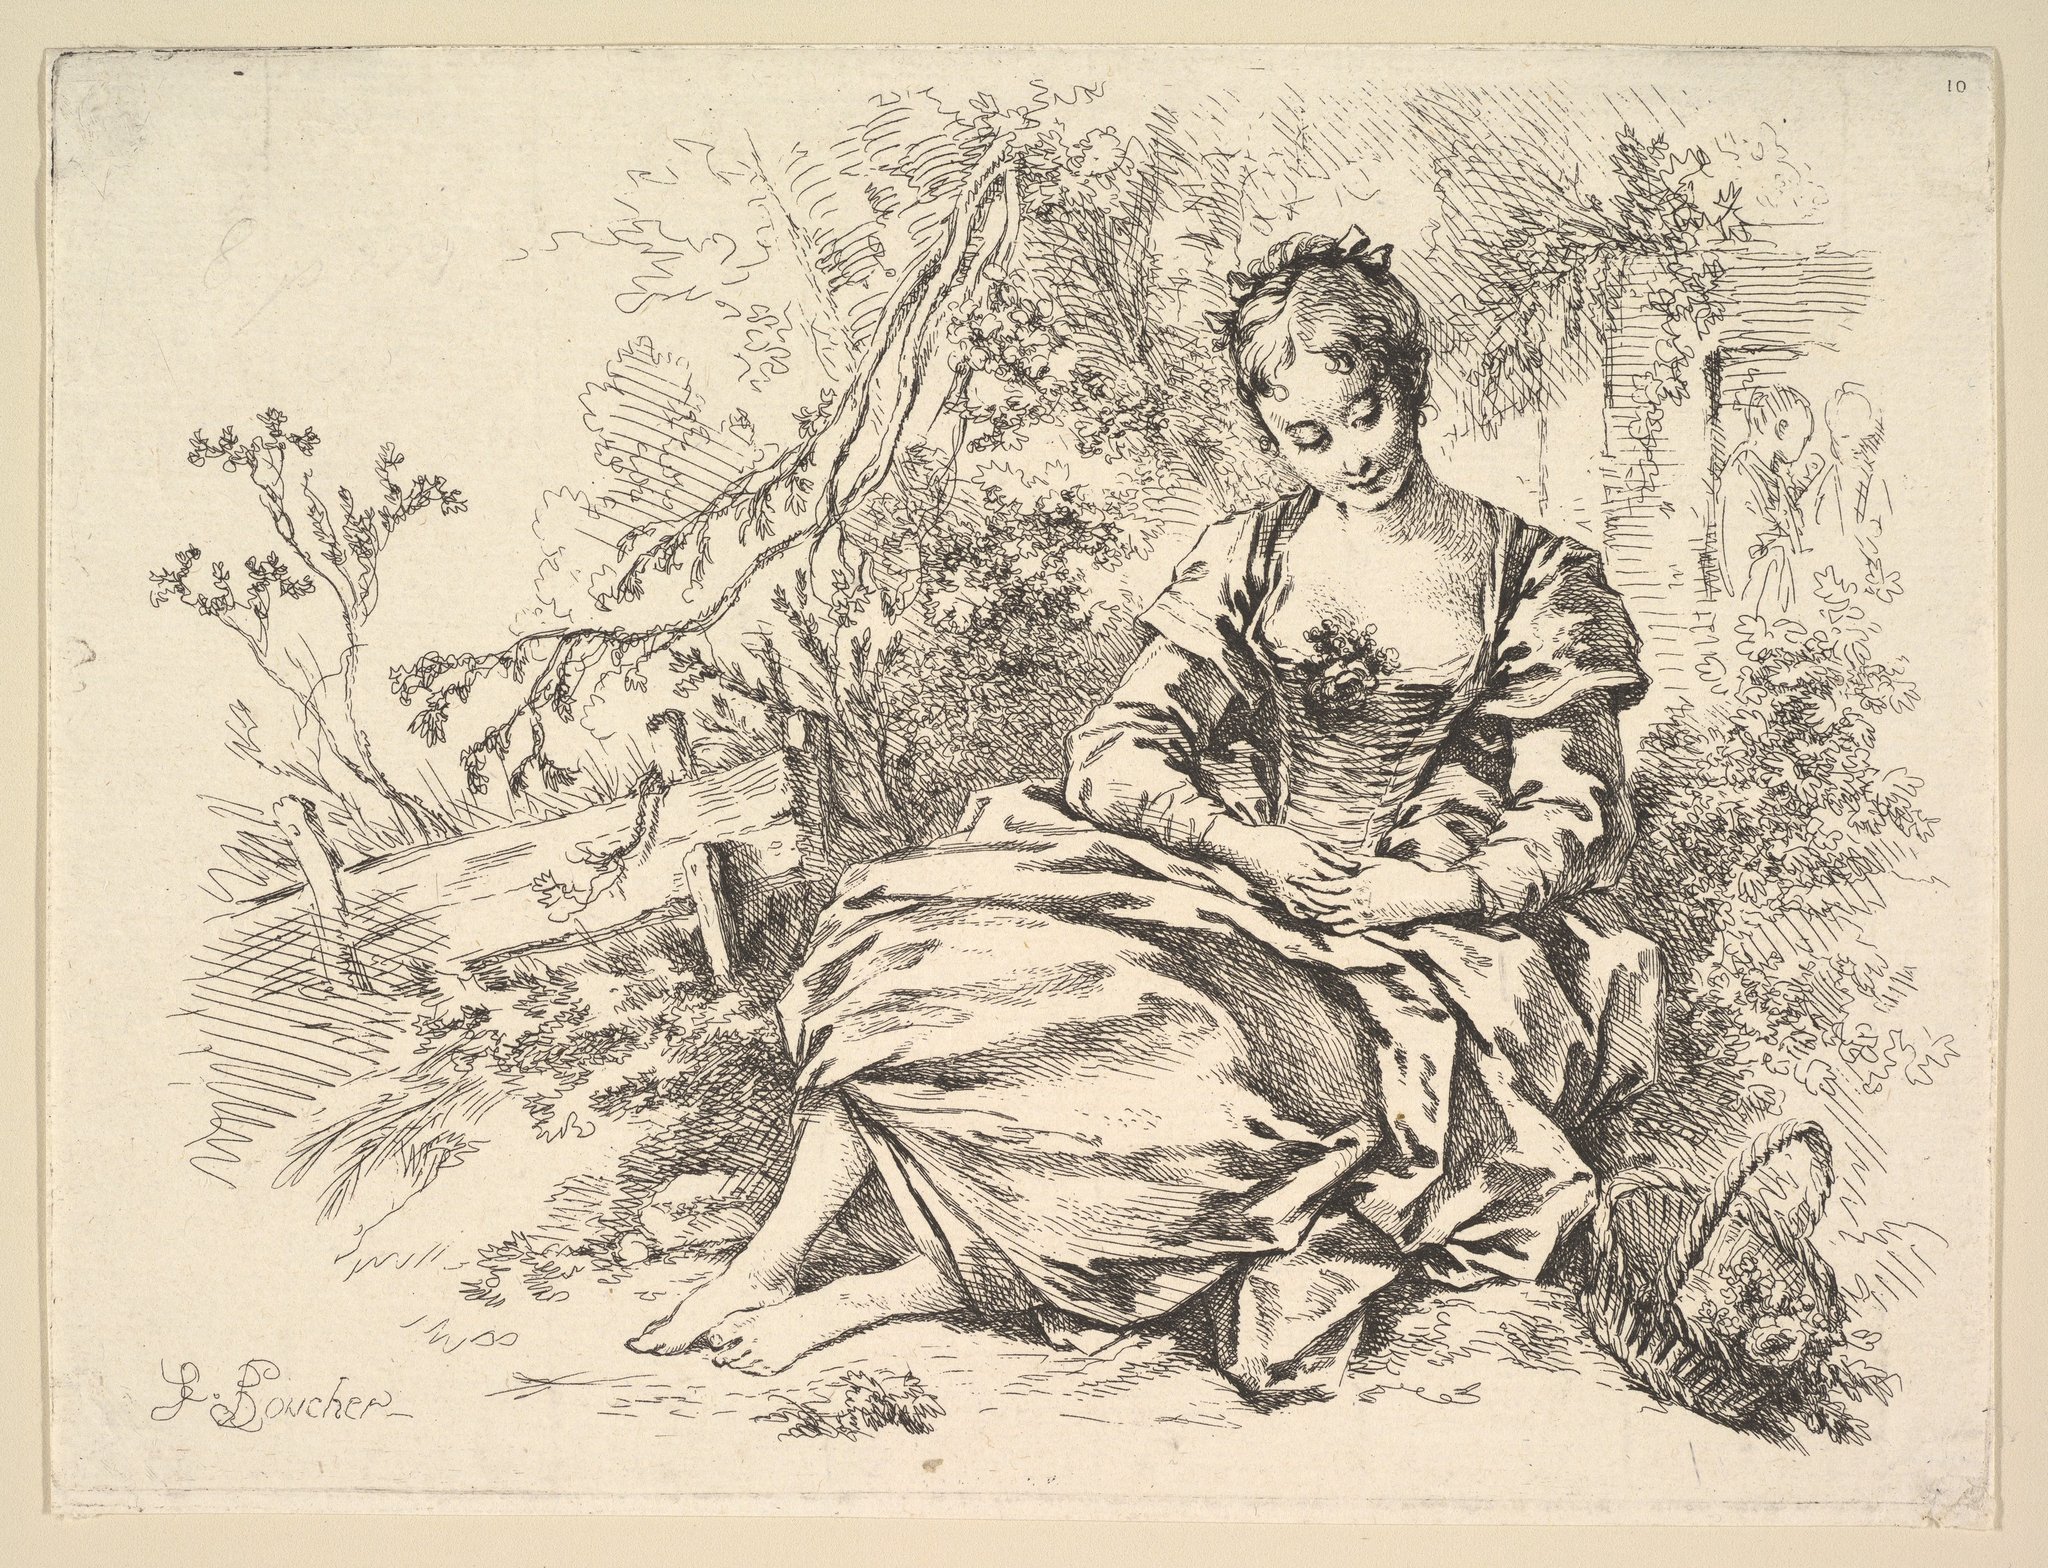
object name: print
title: Girl in a Landscape with a Basket of Flowers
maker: françois boucher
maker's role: artist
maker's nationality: french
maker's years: 1703-1770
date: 1701-1800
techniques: etching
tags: girls,flowers